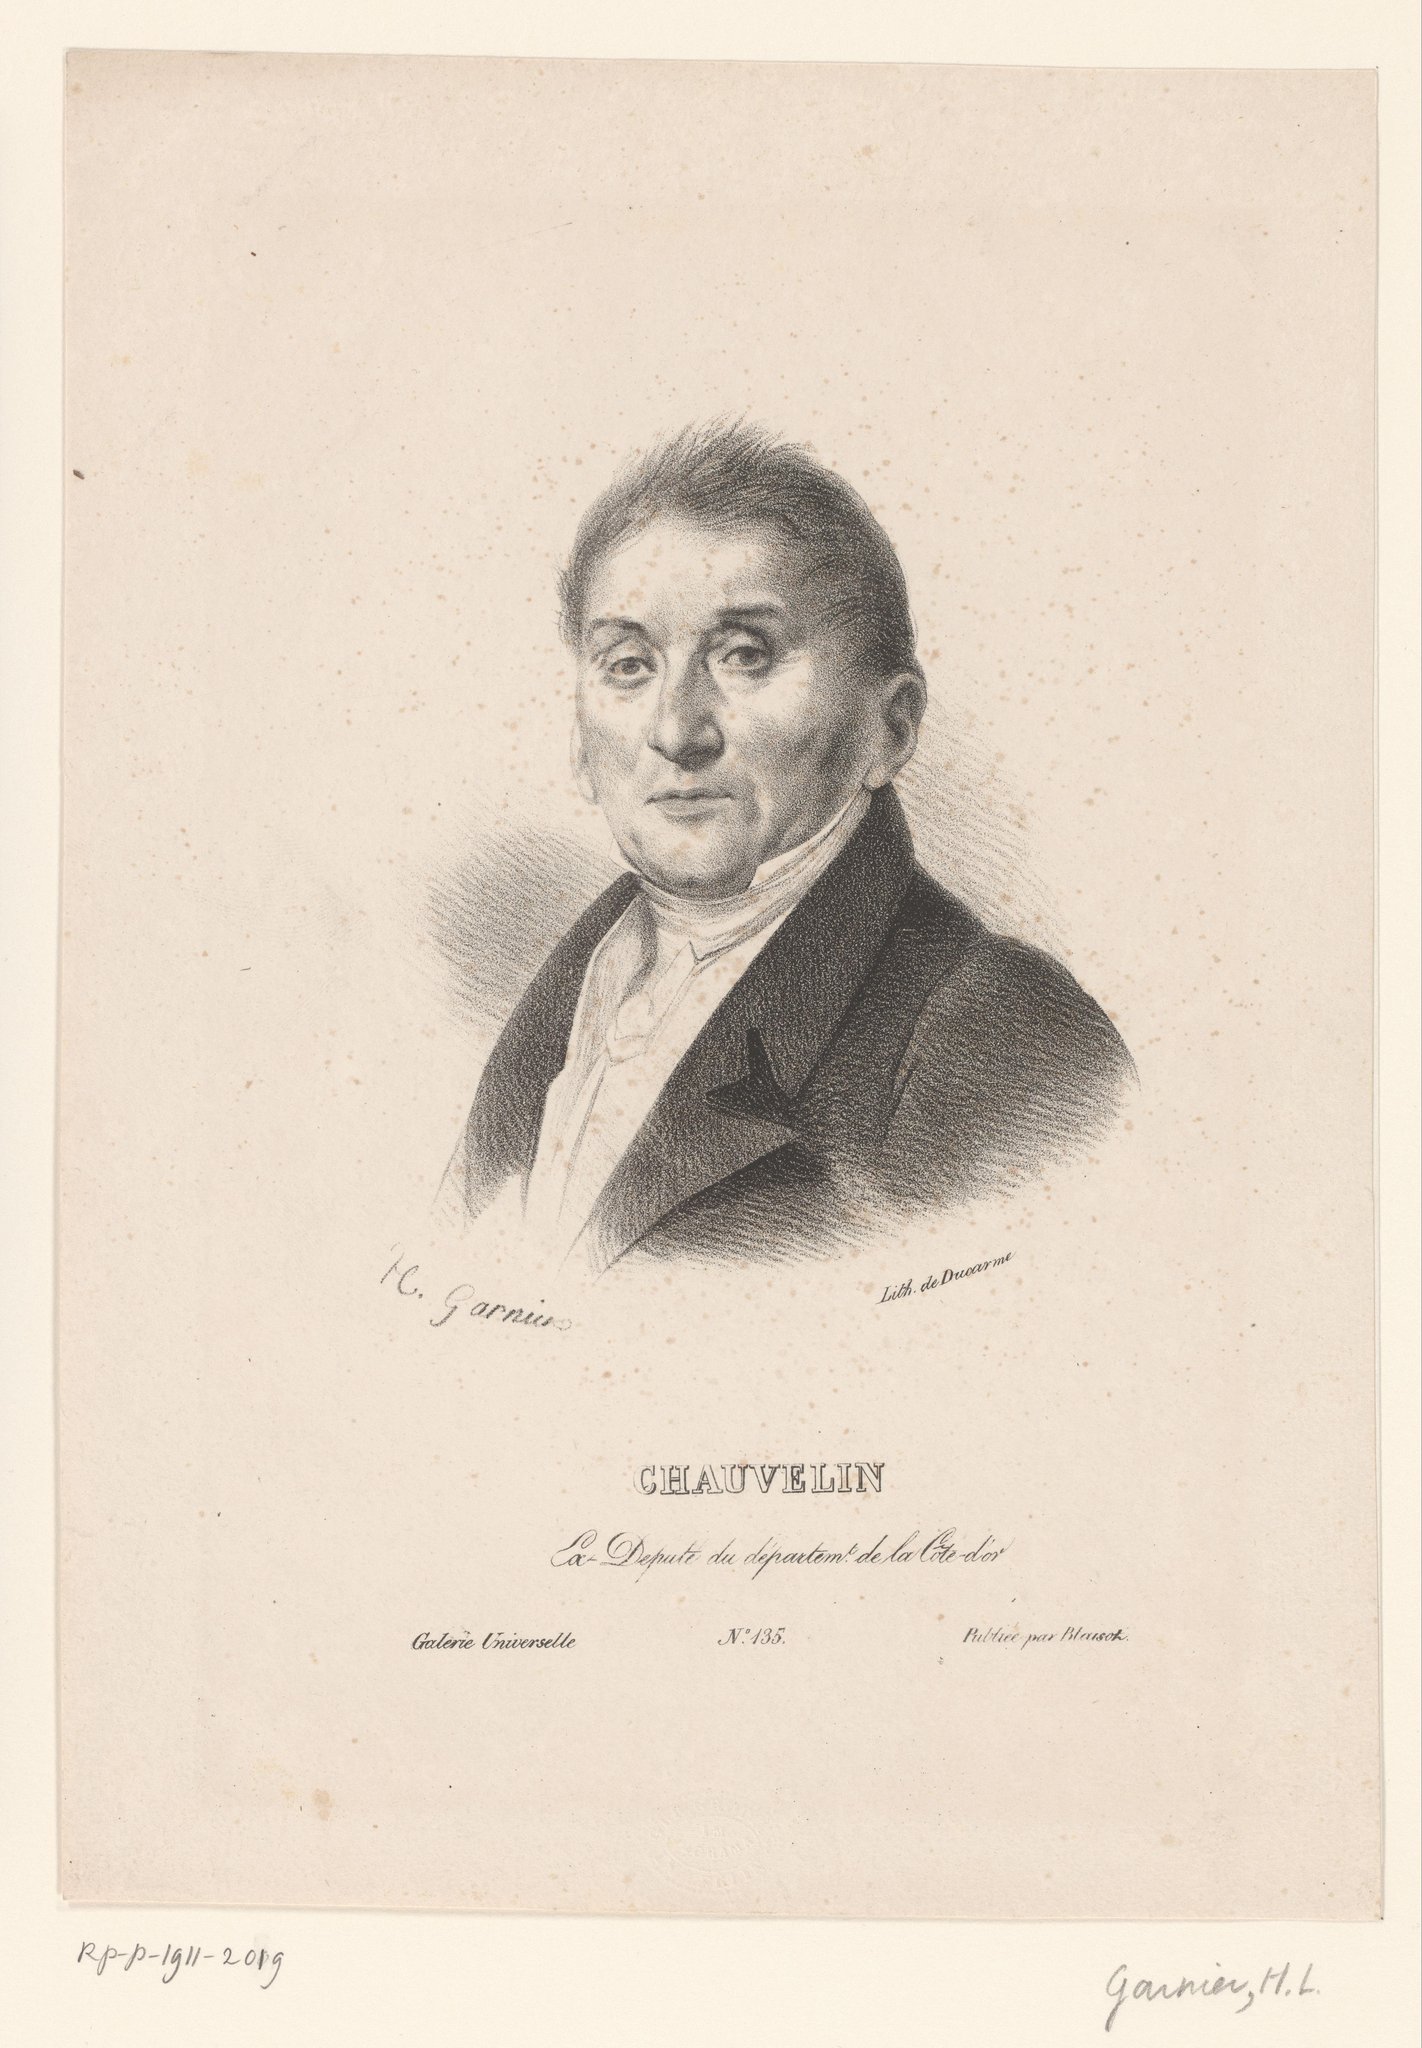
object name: print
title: Portret van François Bernard de Chauvelin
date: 1823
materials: paper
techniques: lithograph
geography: paris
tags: paris, politician, historical persons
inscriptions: check stamp: ‘Gbr. Gropius. / Im Diorama / In Berlin’, collector's mark: Lugt 2228a